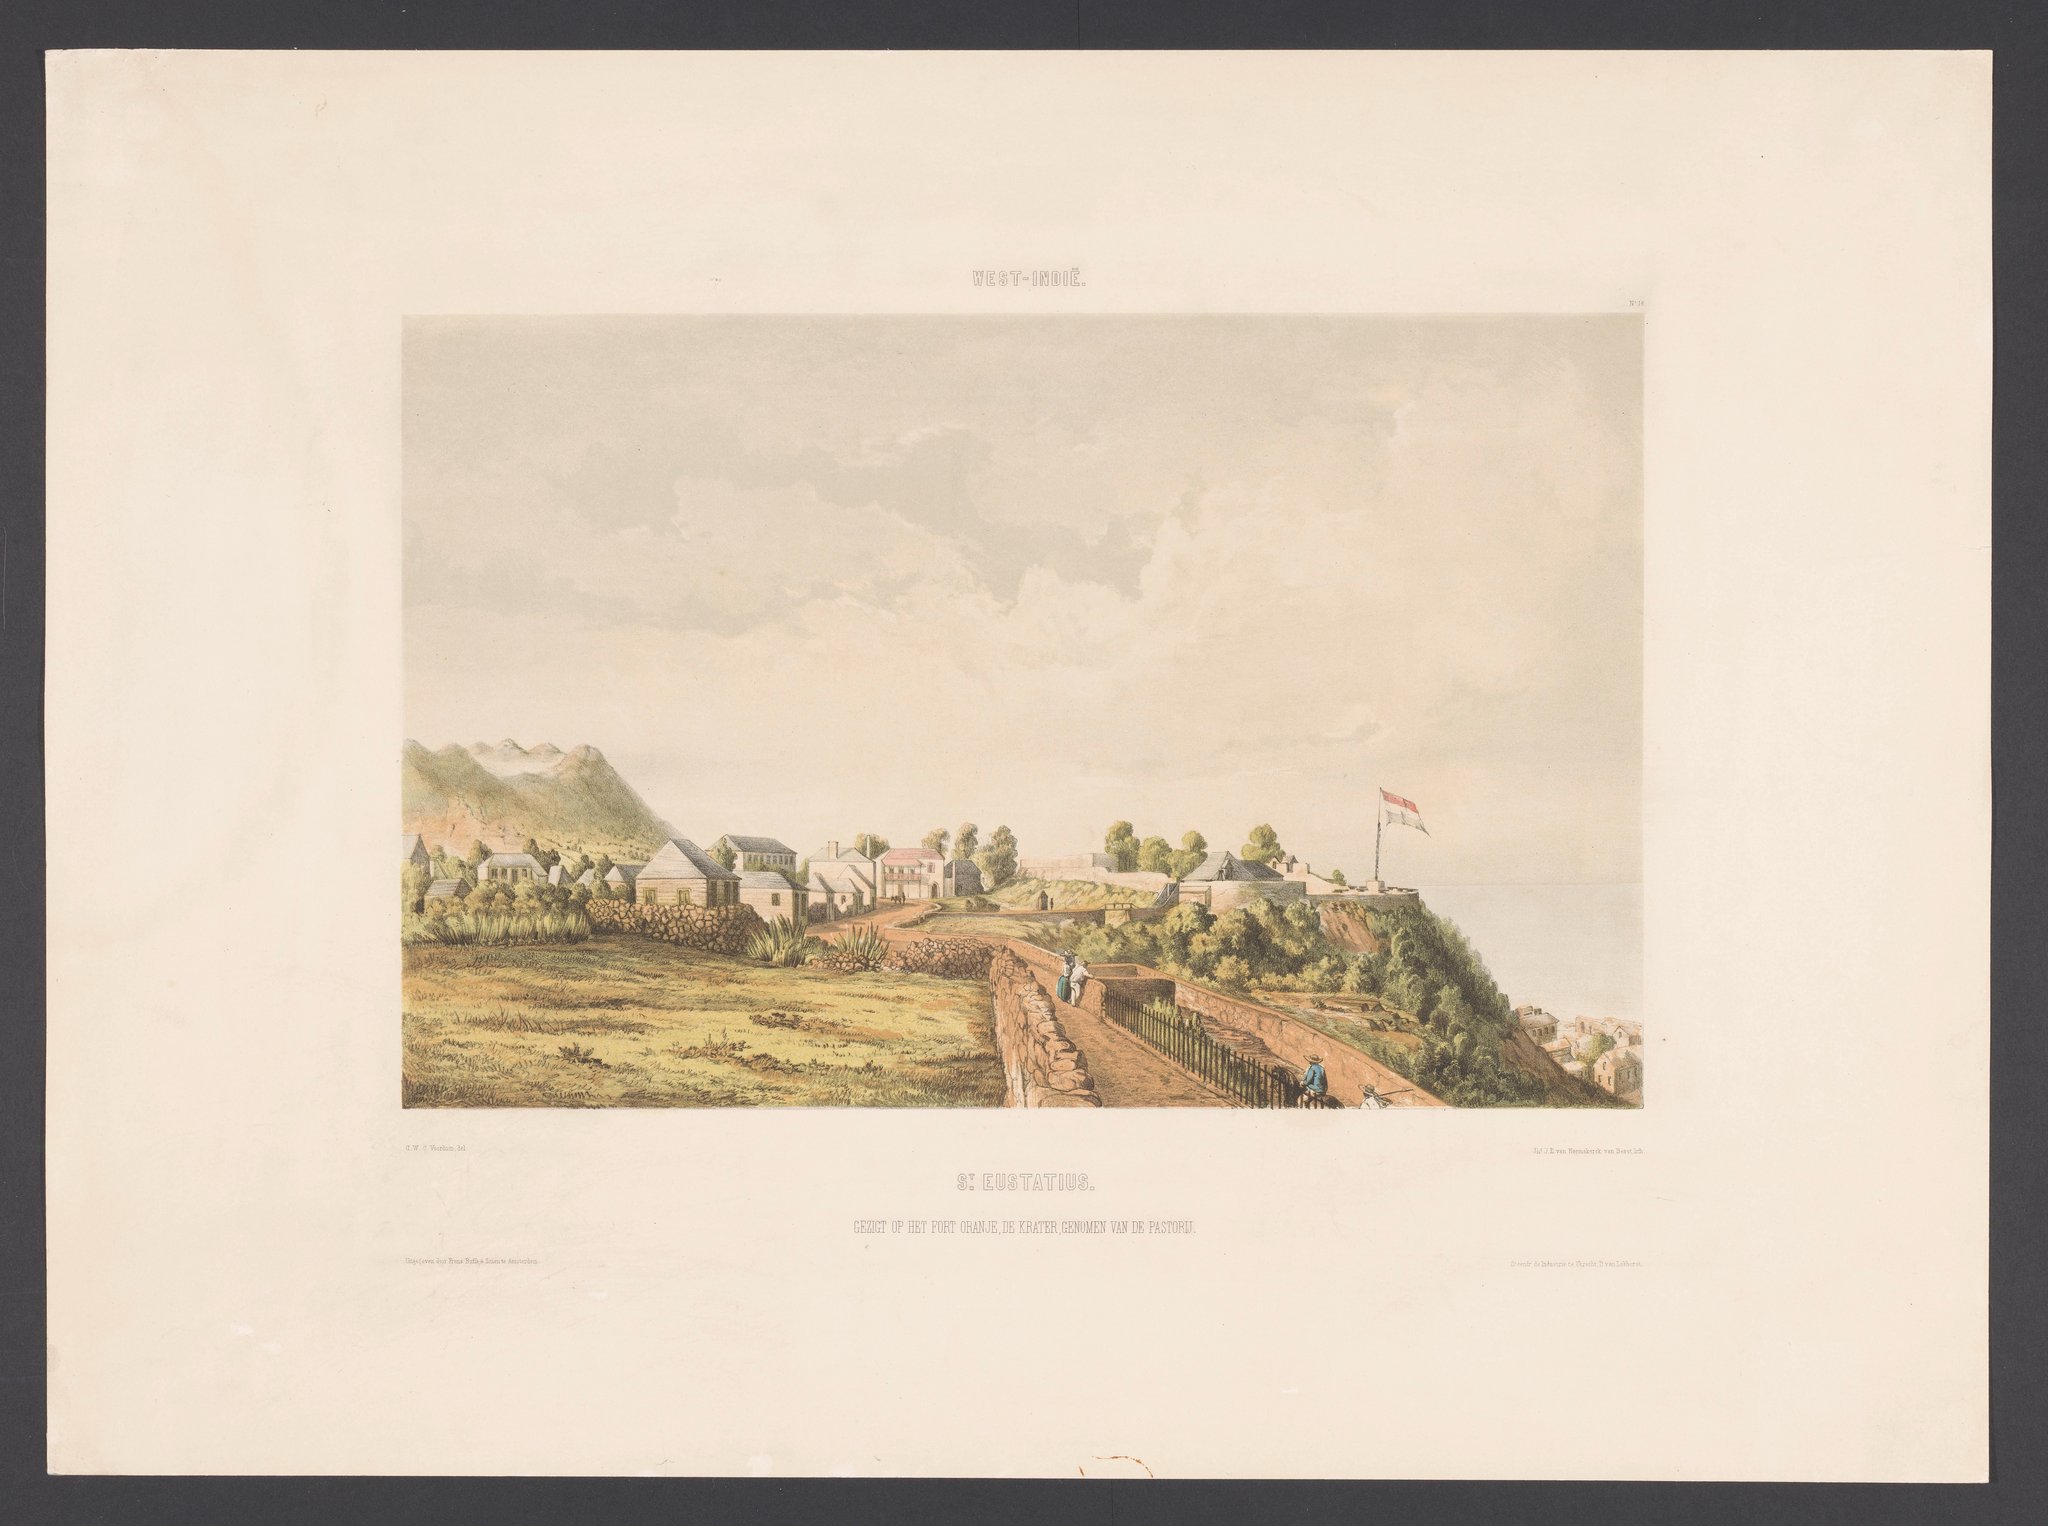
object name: print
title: Gezigten uit Neerland's West-Indien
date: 1860-1862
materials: paper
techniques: lithograph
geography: netherlands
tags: fortress, volcano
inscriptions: collector's mark: Lugt 2760, collector's mark: Lugt 2228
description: Gezicht op het Fort Oranje in Oranjestad op Sint-Eustatius. Links in de verte de vulkaan The Quill (verengelsing van de Nederlandse benaming De Kuil of De Kwil). Prent maakt deel uit van een omslag met zeventien bladen.